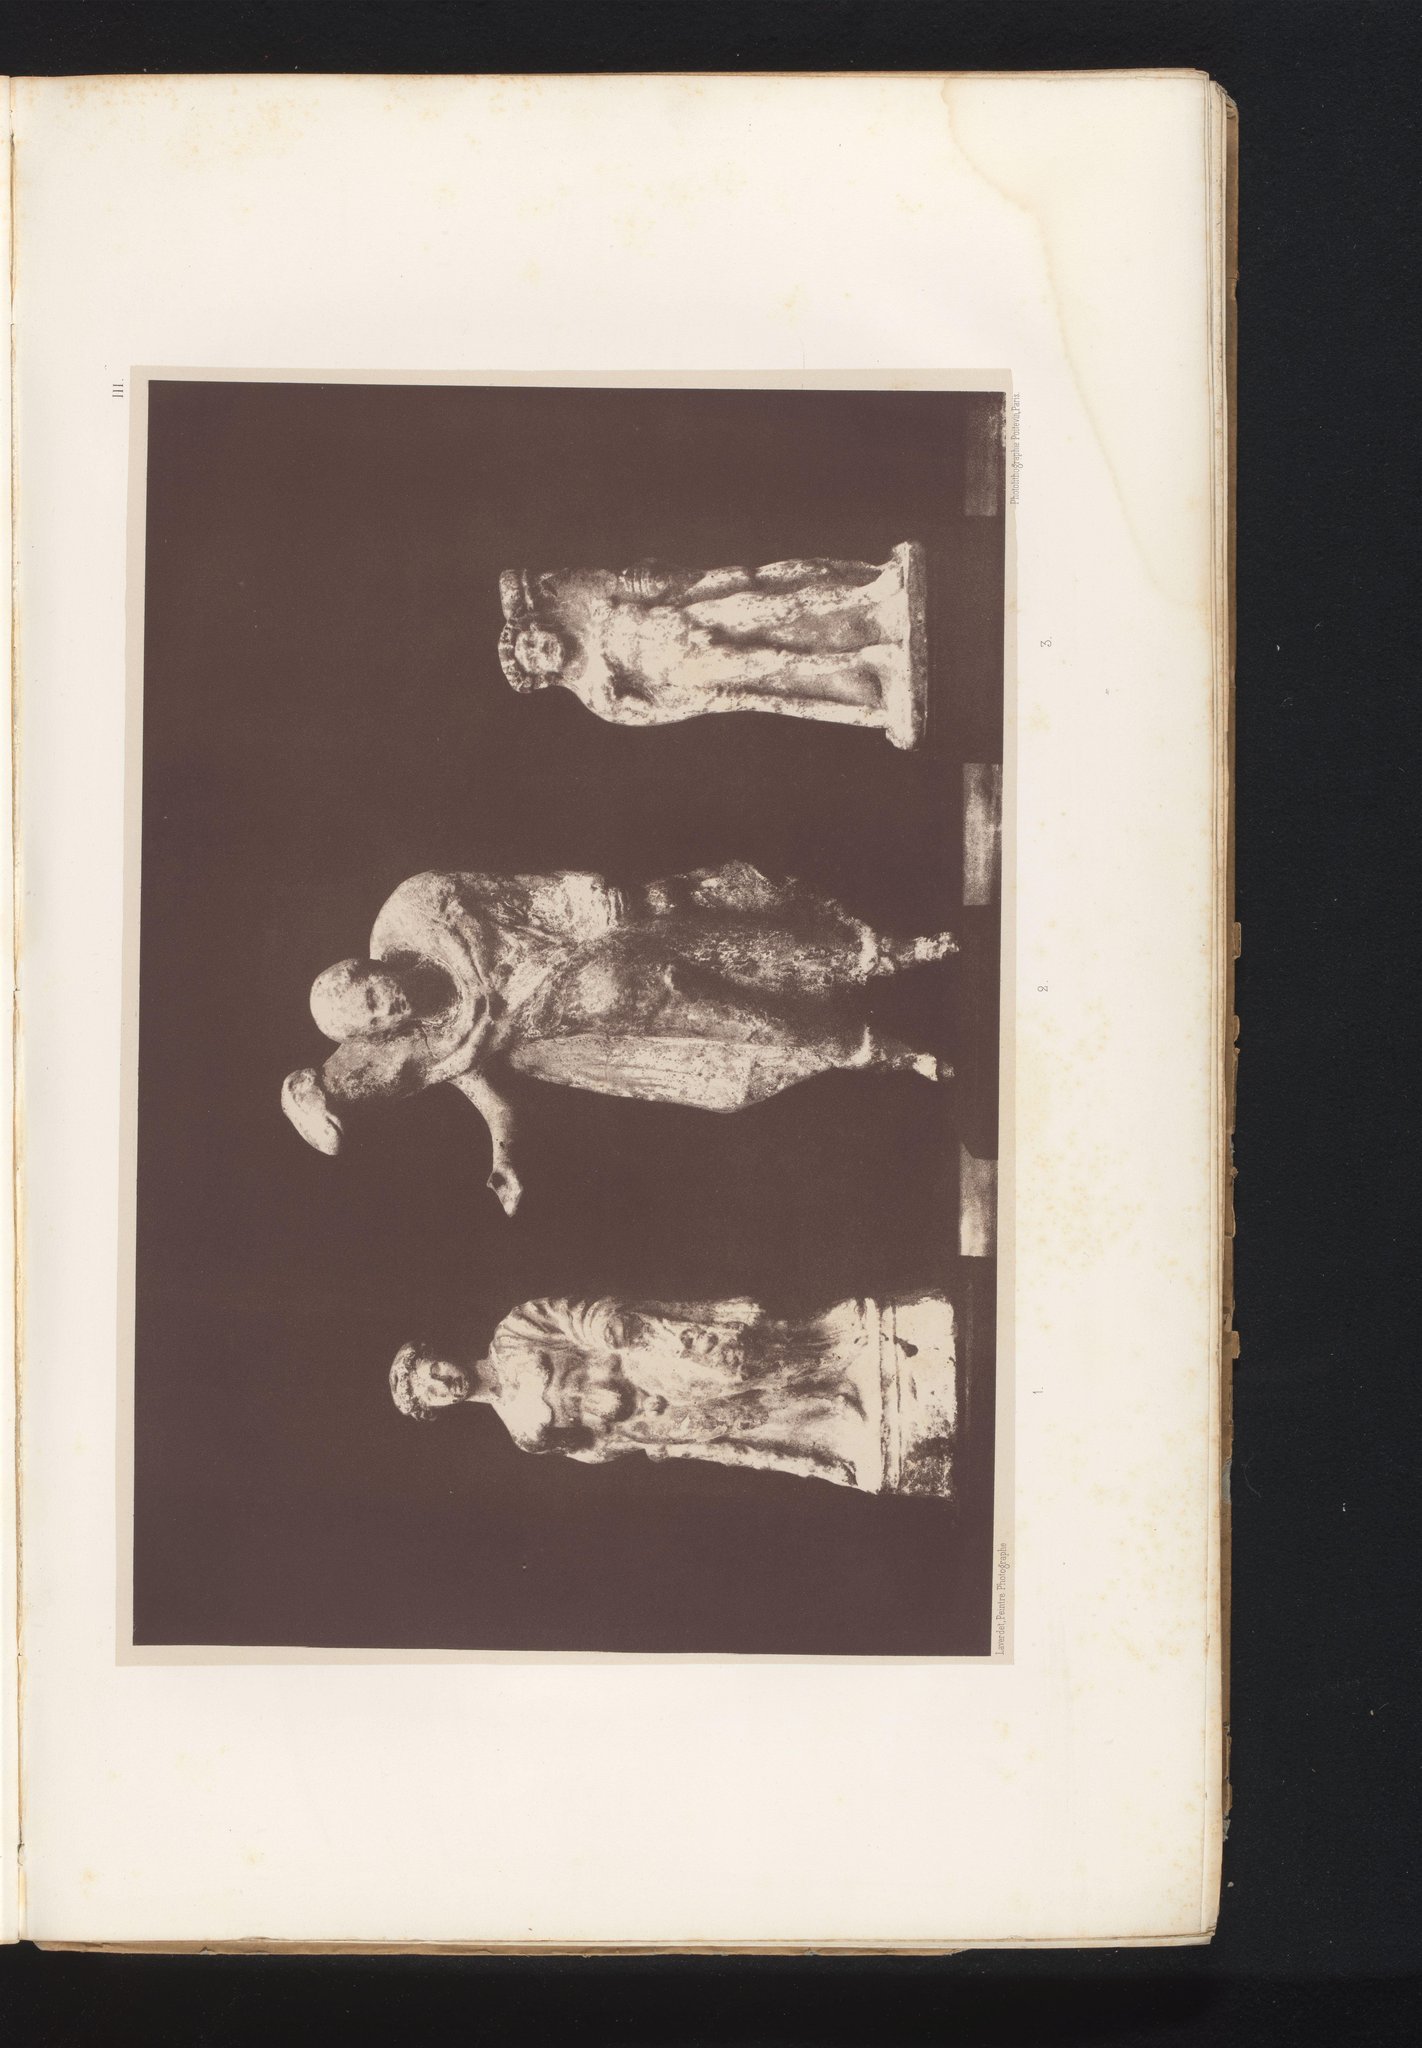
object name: page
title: Drie terracotta sculpturen van Theseus, Mercurius Criophorus en Hercules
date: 1852-1857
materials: paper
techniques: photolithography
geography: paris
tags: (story of) hercules (heracles), piece of sculpture, reproduction of a piece of sculpture (+ clay, sand, etc. ~ arts), (story of) theseus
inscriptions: number: ‘III.’, number: ‘1. 2. 3.’